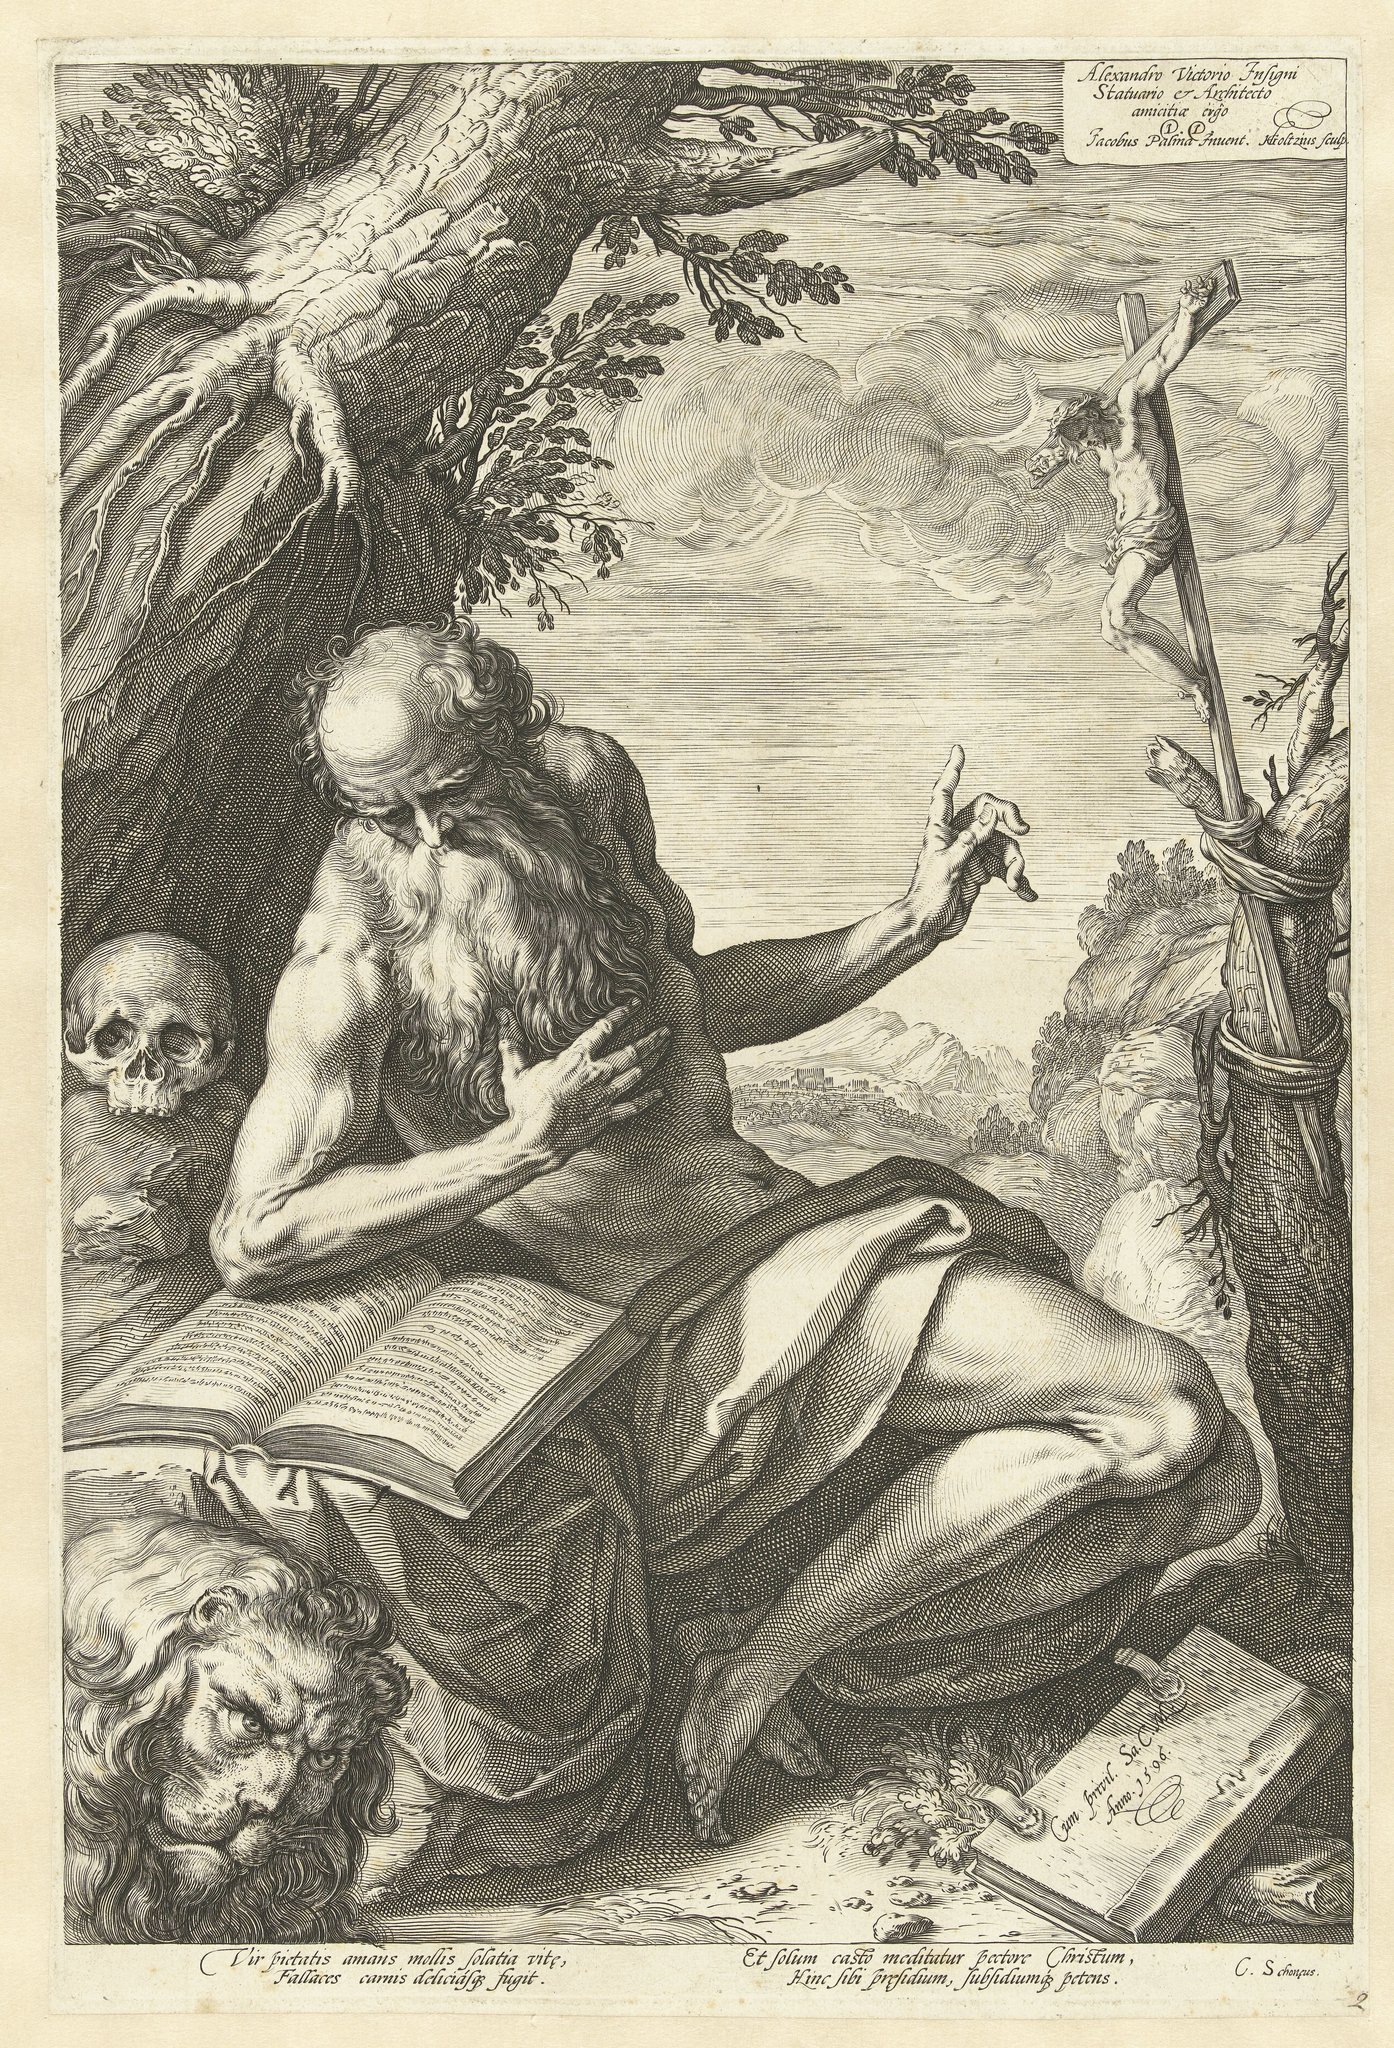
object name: print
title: Heilige Hieronymus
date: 1596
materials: paper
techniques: engraving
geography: haarlem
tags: the monk and hermit jerome (hieronymus); possible attributes: book, cardinal's hat, crucifix, hour-glass, lion, skull, stone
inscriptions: collector's mark: Lugt 11, collector's mark: Lugt 10, collector's mark: ‘Hinloopen’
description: De heilige Hieronymus, zittend onder een boom, lezend in een boek, de linkerhand wijzend naar een crucifix, bij zijn voeten een leeuw. Onder de voorstelling vier regels Latijn.